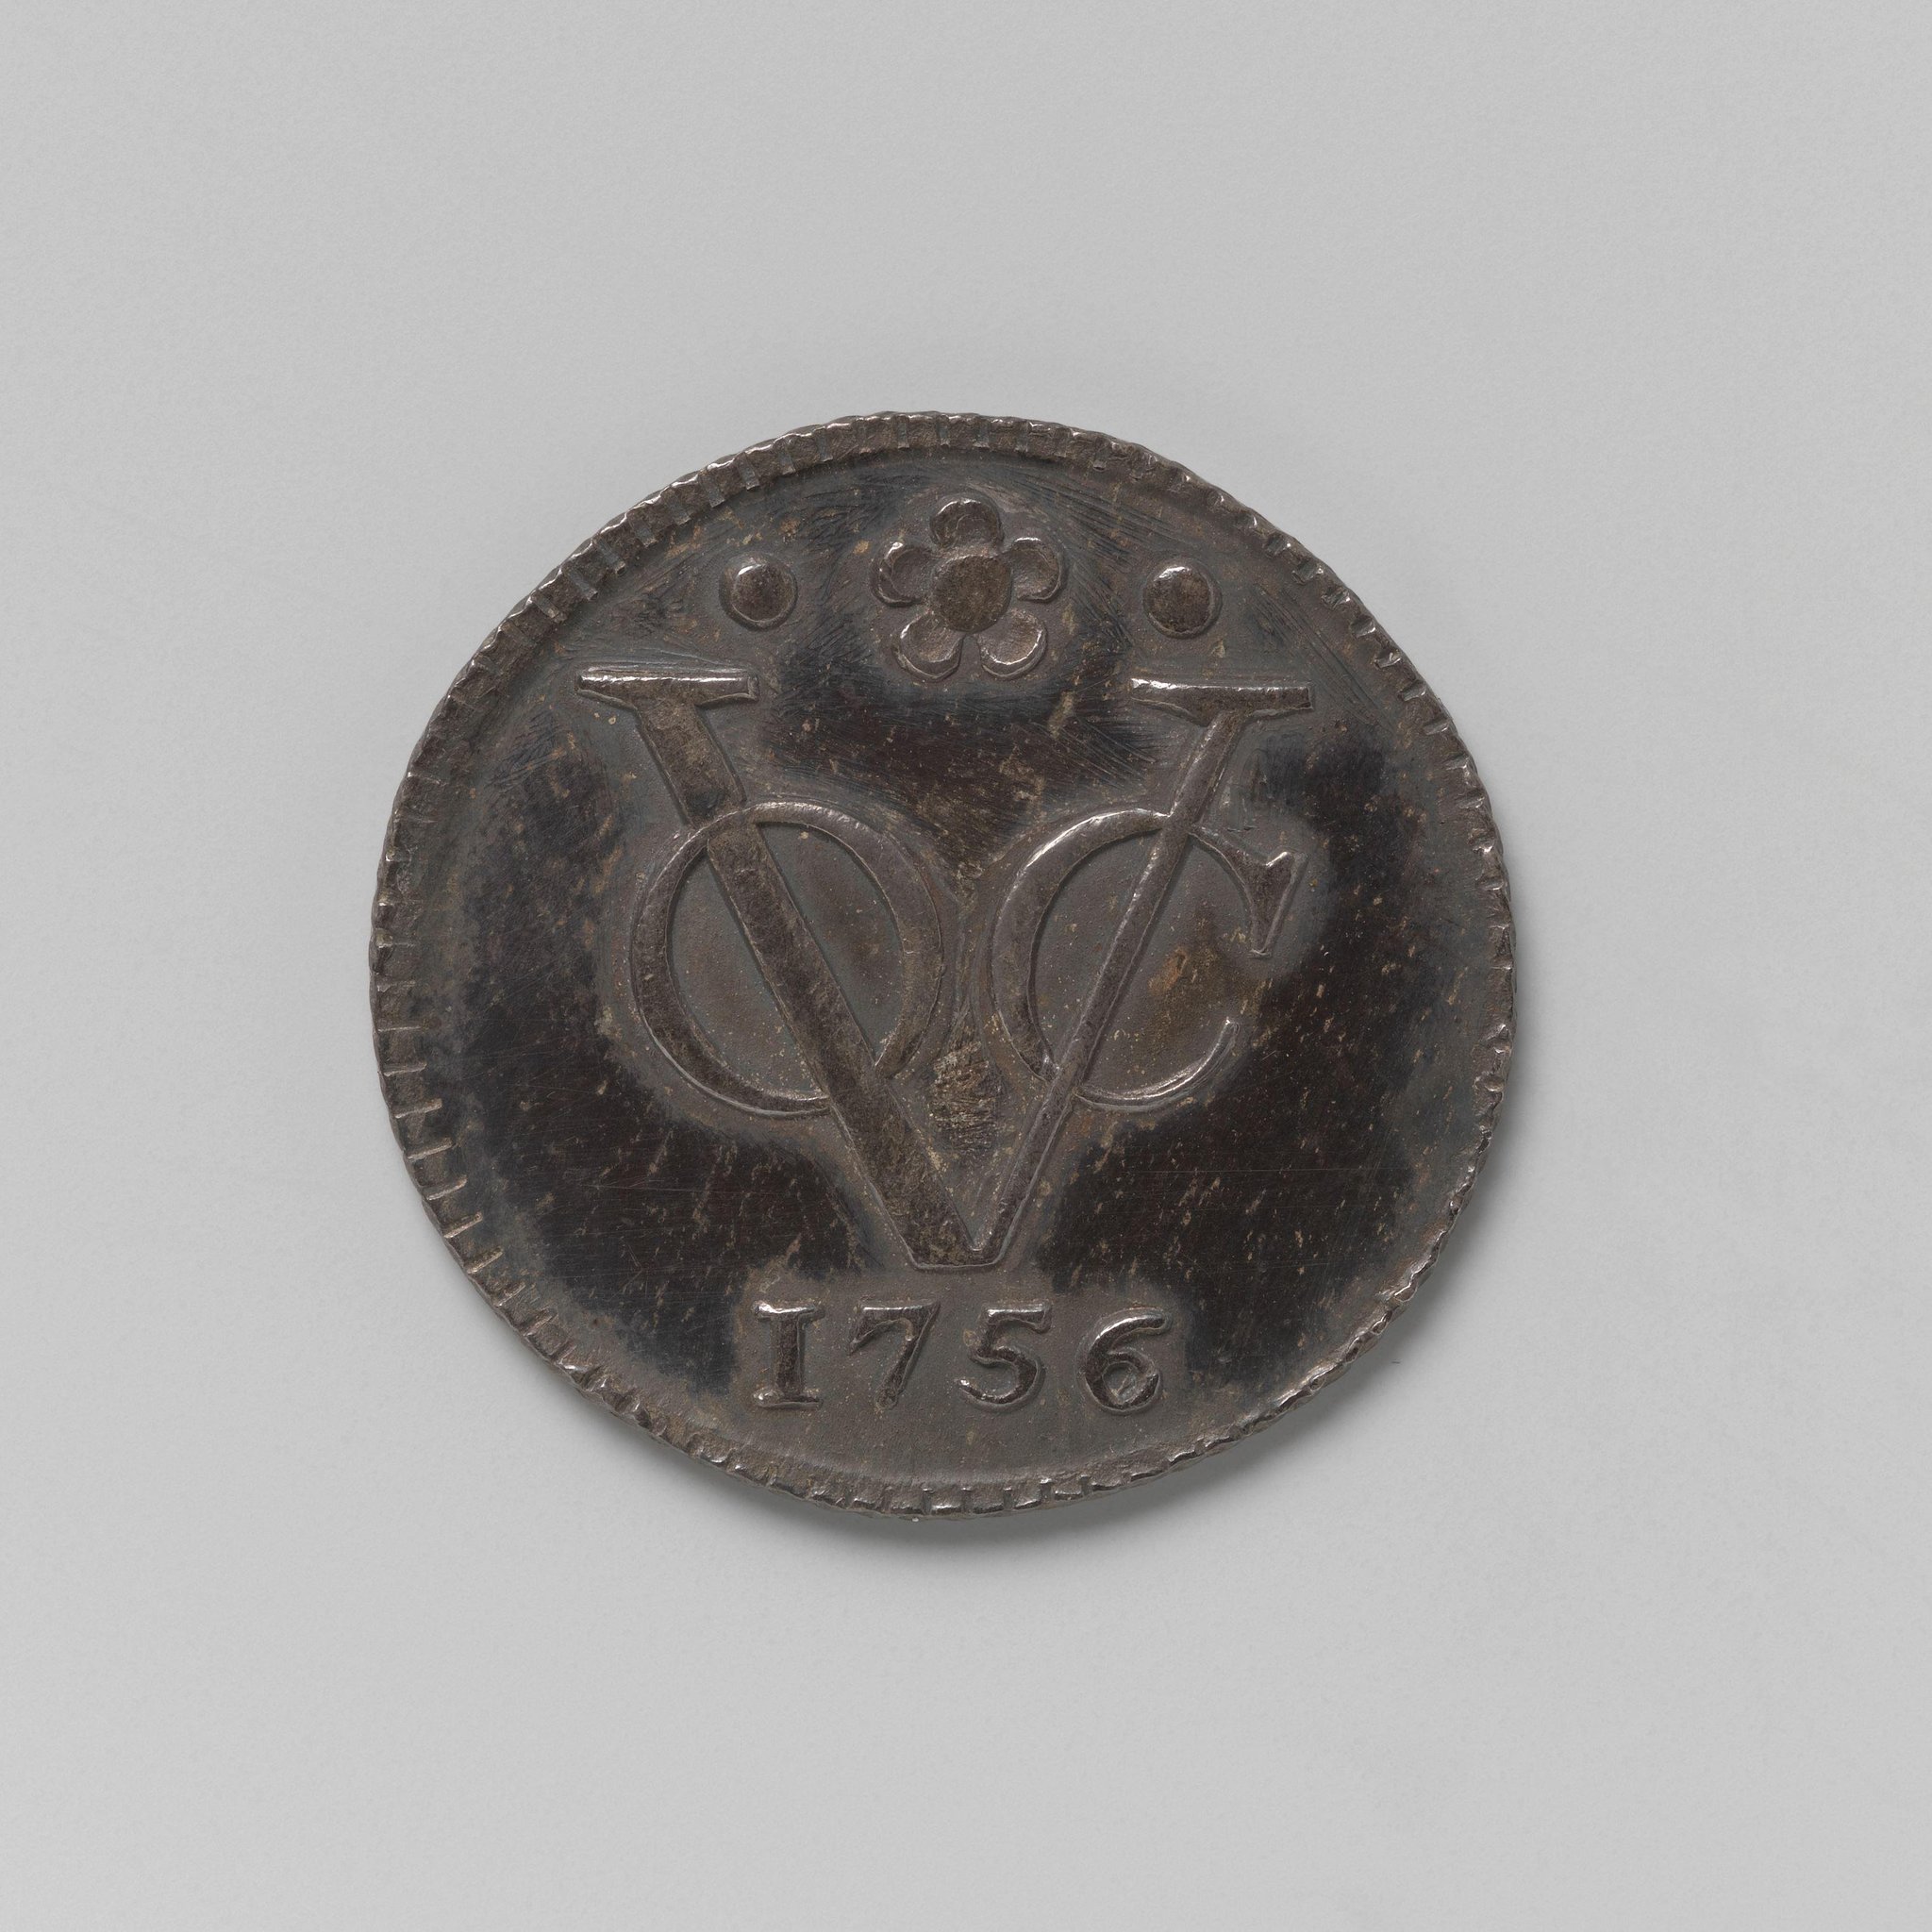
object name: coin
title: Zilveren afslag van een ½ duit van de VOC uit Holland, 1756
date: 1756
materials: silver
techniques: striking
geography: dordrecht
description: Zilveren munt. Voorzijde: gekroond wapenschild van Holland. Keerzijde: monogram van de VOC, waarboven muntteken en waaronder jaartal. Kabelrand.